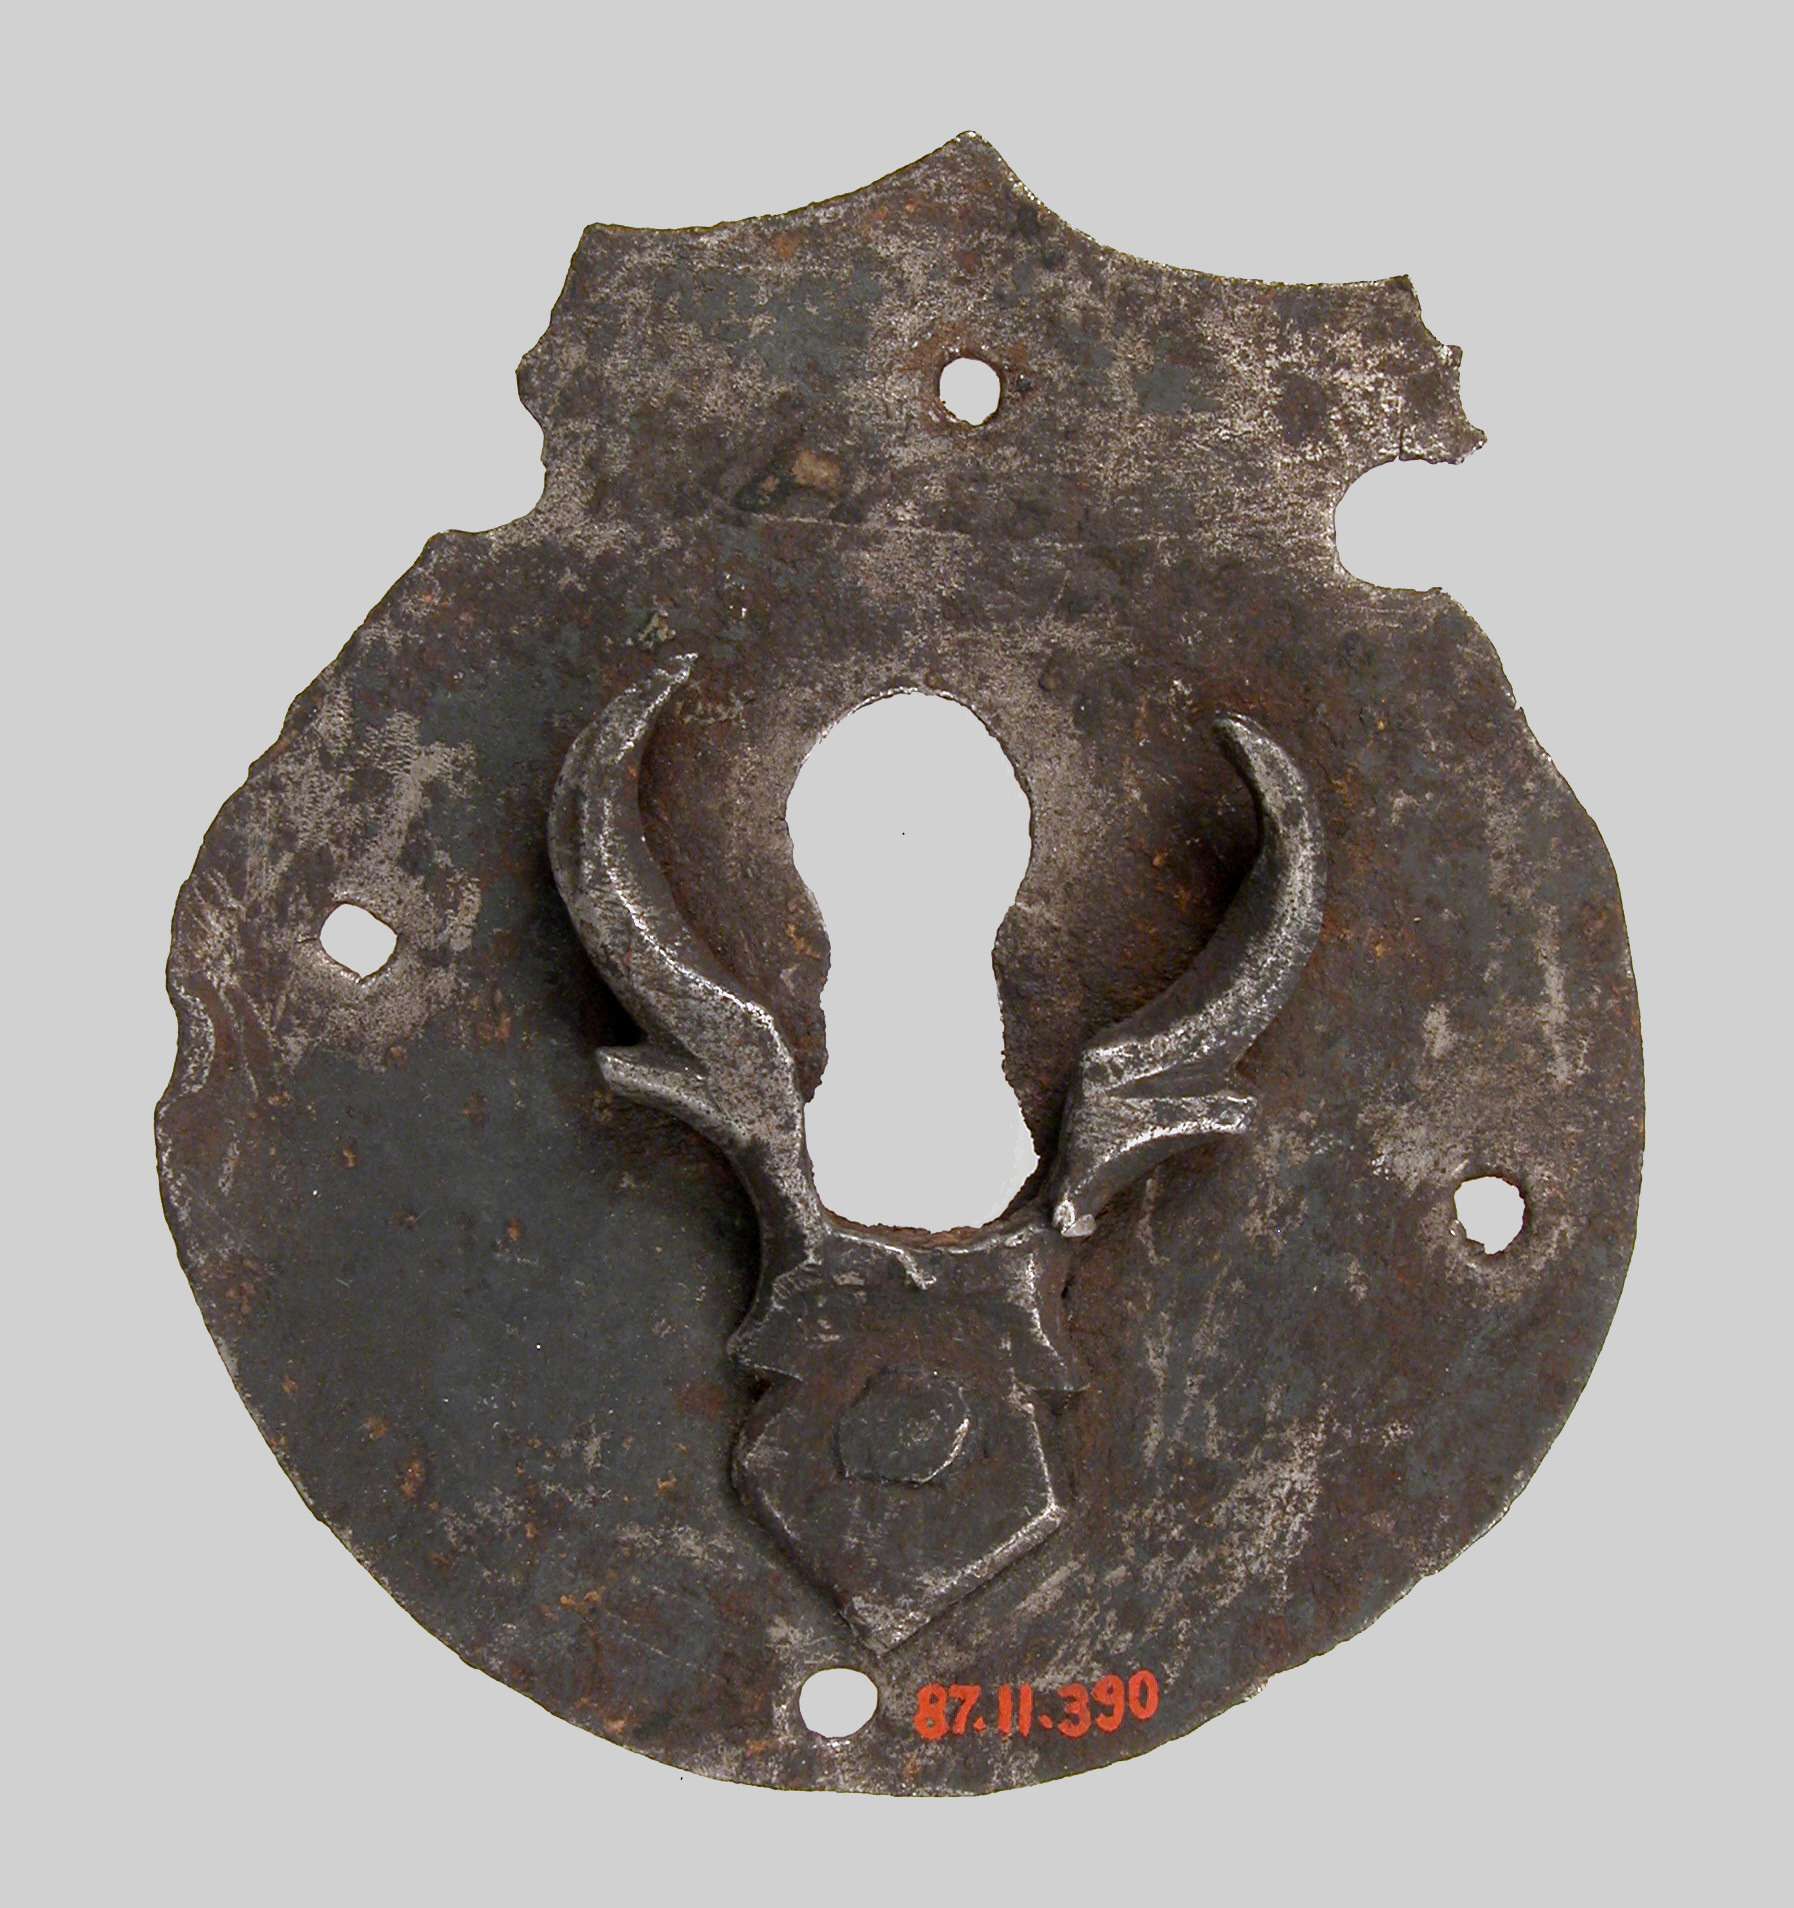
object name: escutcheon plate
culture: german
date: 1501-1600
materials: iron